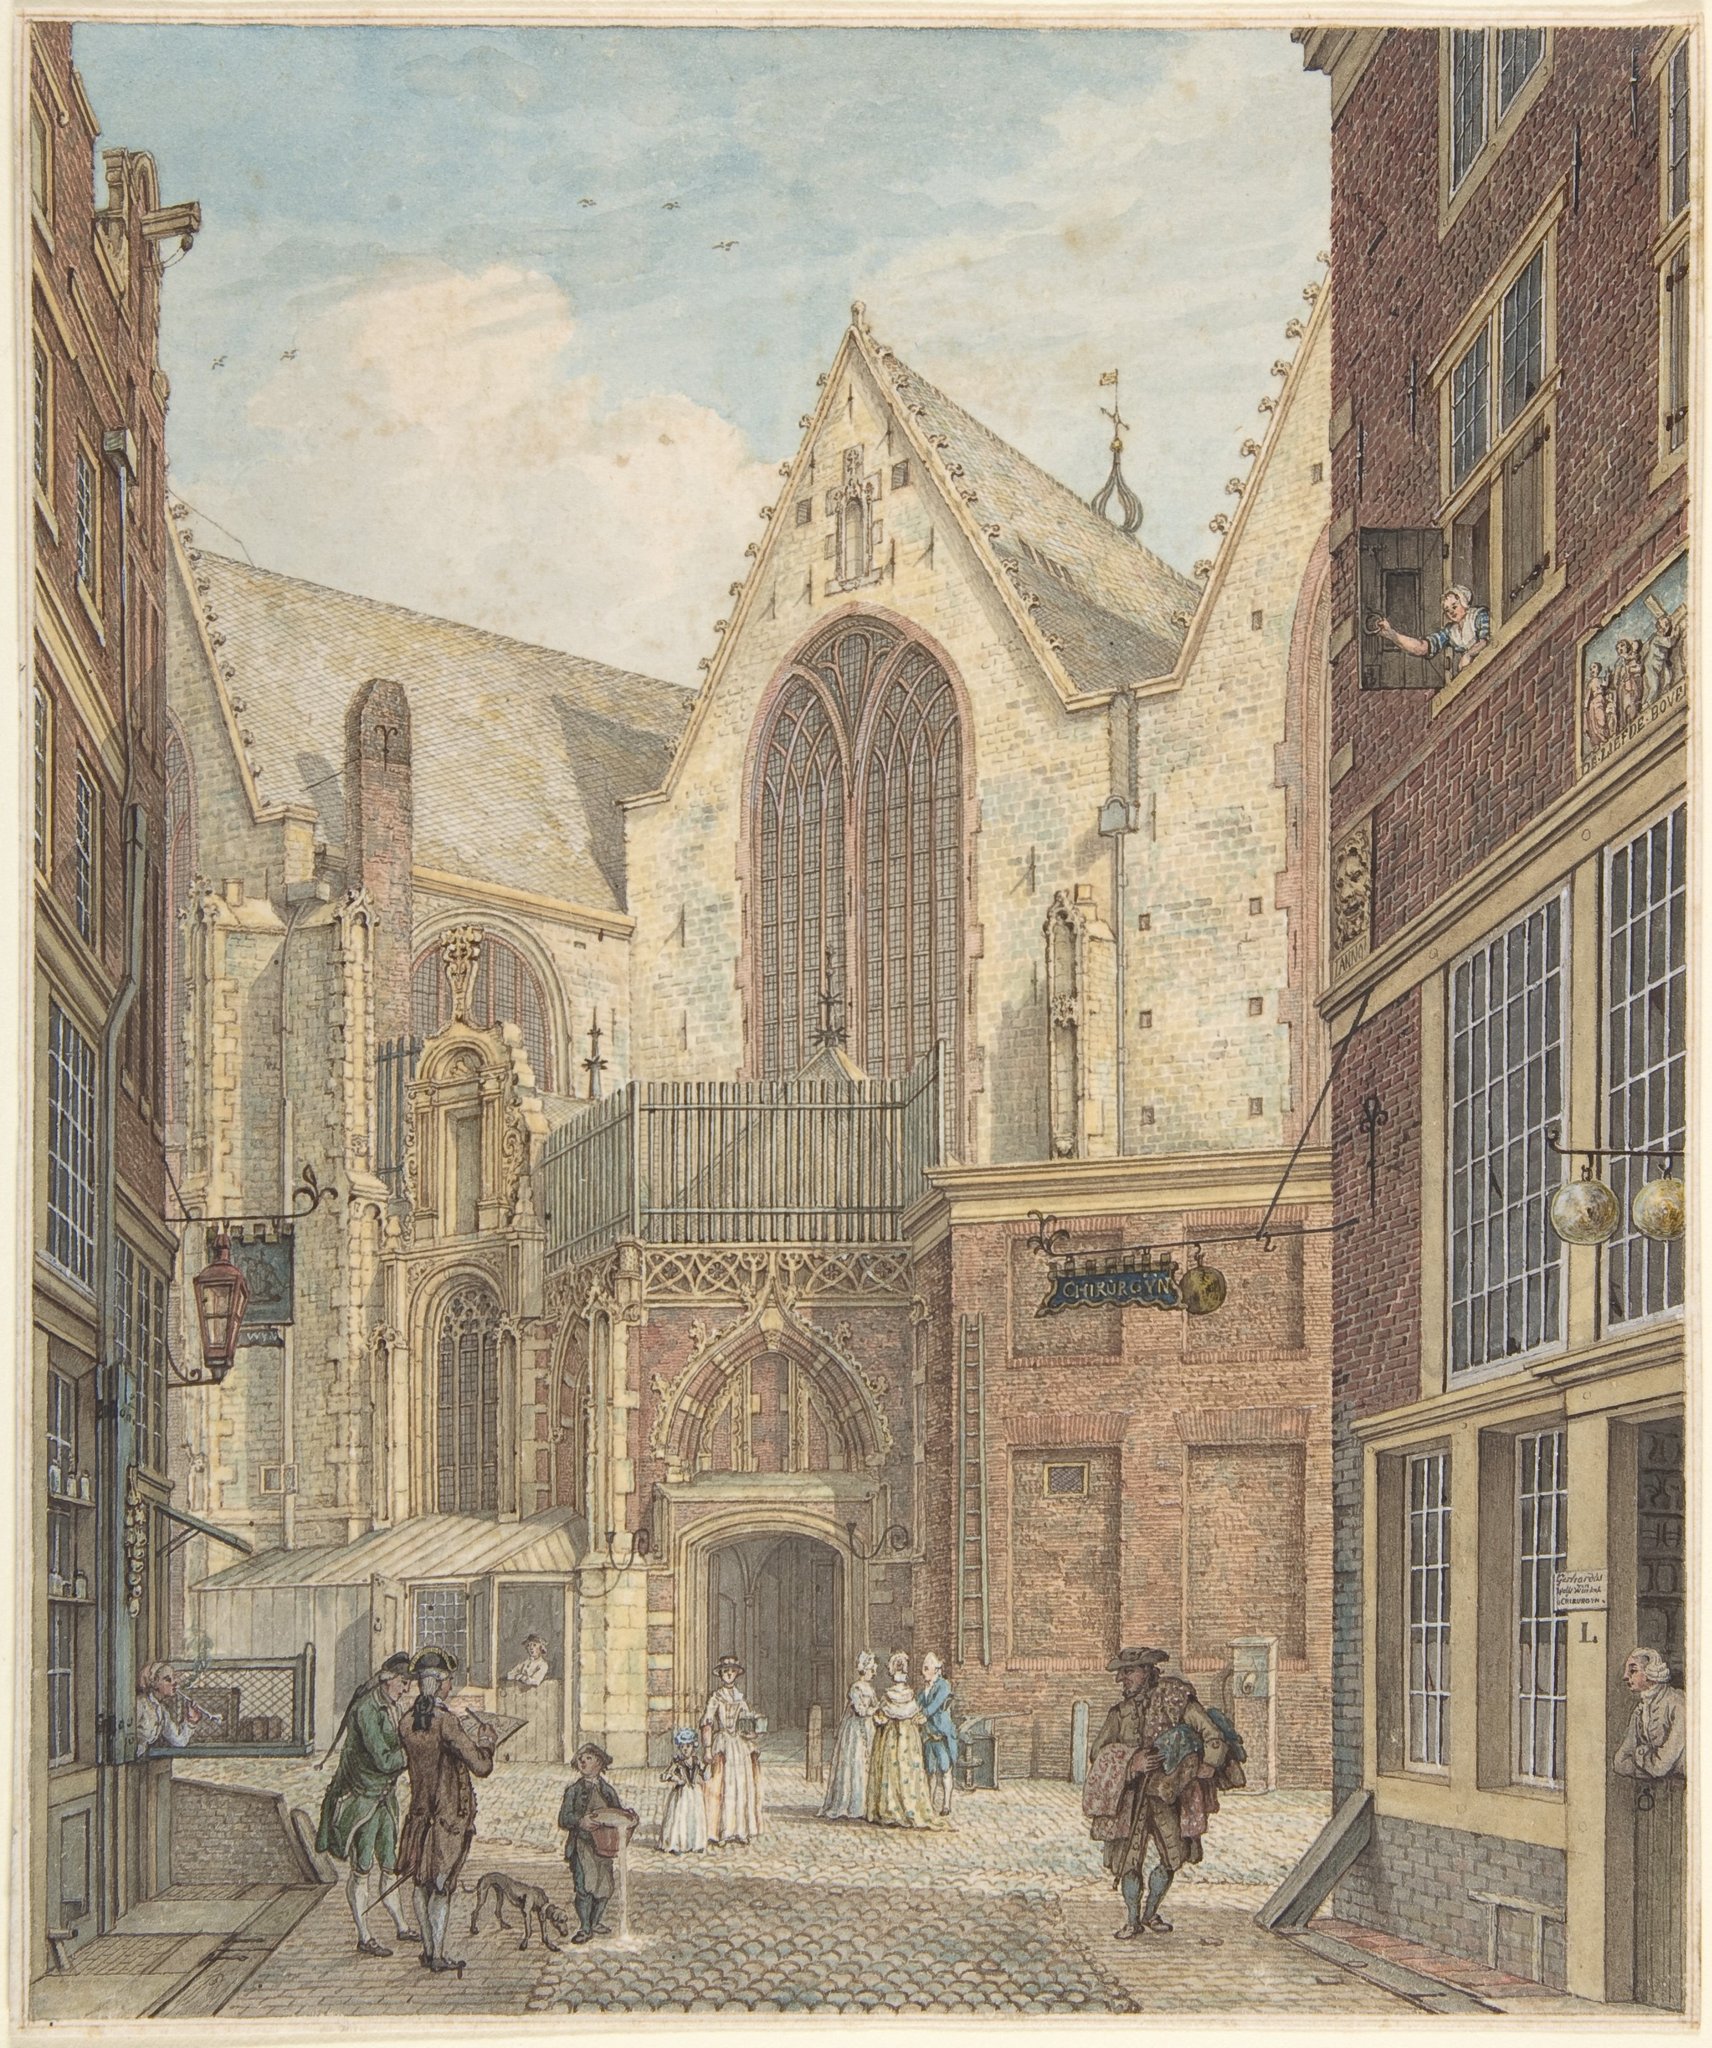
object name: drawing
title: View of the Old Church of Amsterdam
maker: hermanus petrus schouten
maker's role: artist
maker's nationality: dutch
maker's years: 1747-1822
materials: ink, watercolor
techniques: pen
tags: churches,amsterdam